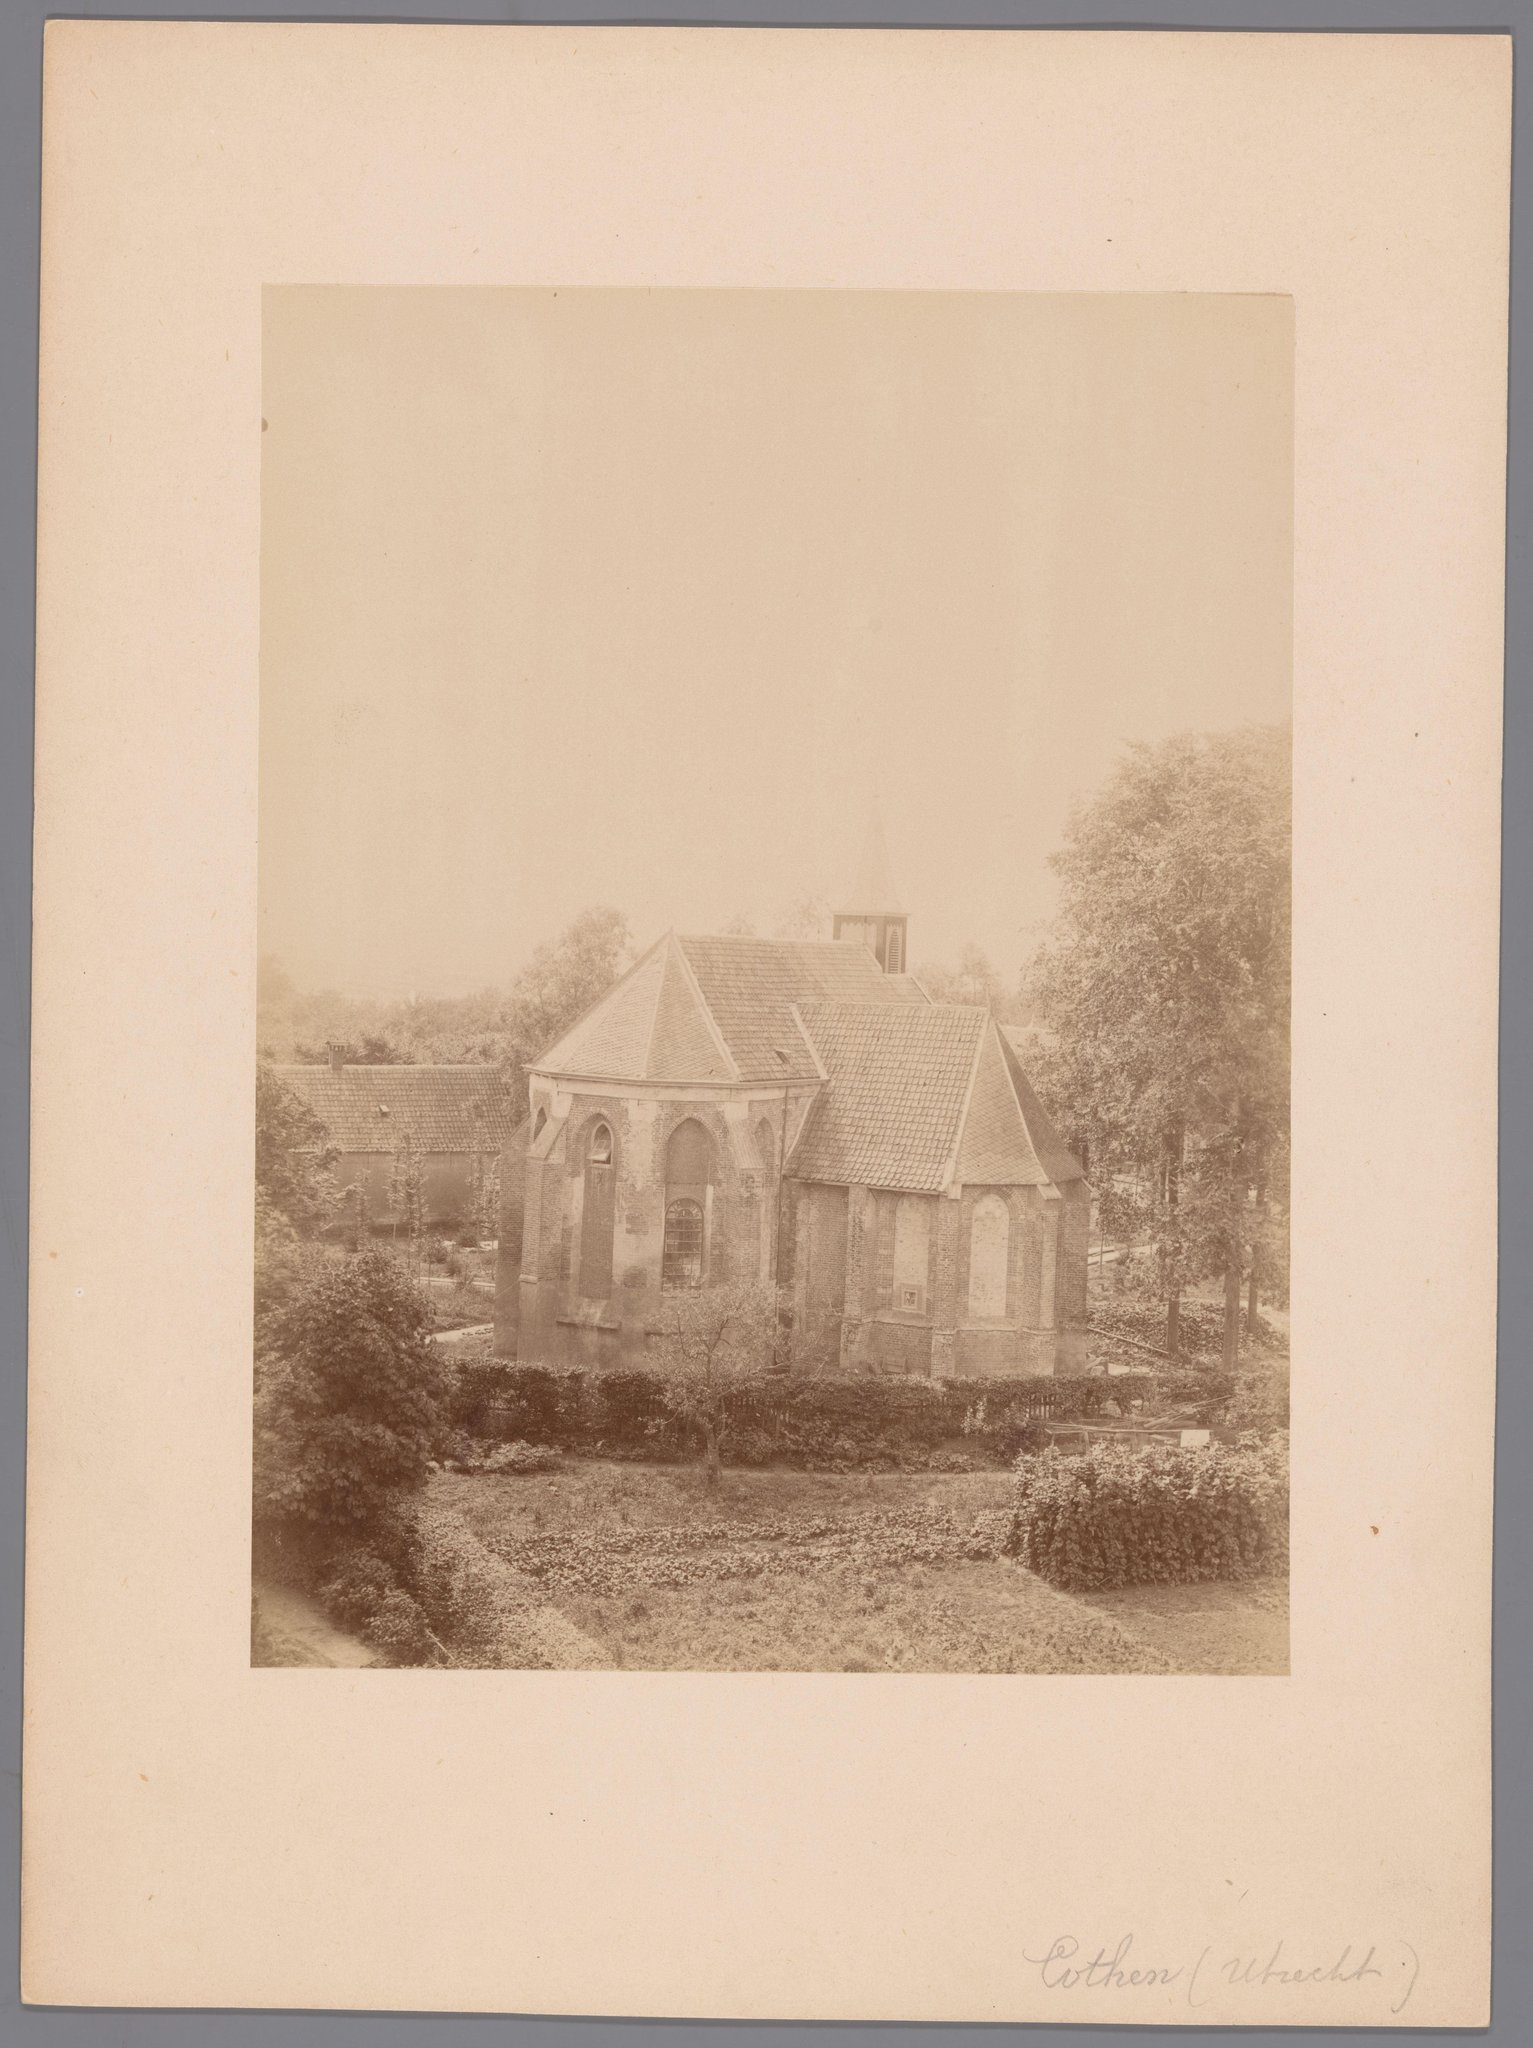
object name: photograph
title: Gezicht op de Sint-Agneskerk te Cothen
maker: anoniem (monumentenzorg)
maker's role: fotograaf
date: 1890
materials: cardboard, photographic support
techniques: albumen print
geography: cothen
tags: church (exterior)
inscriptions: annotation: ‘Kerk te Cothen (Utrecht)/ van of op het huis van de burgemeester/ aug 1890’, annotation: ‘Cothen (Utrecht)’